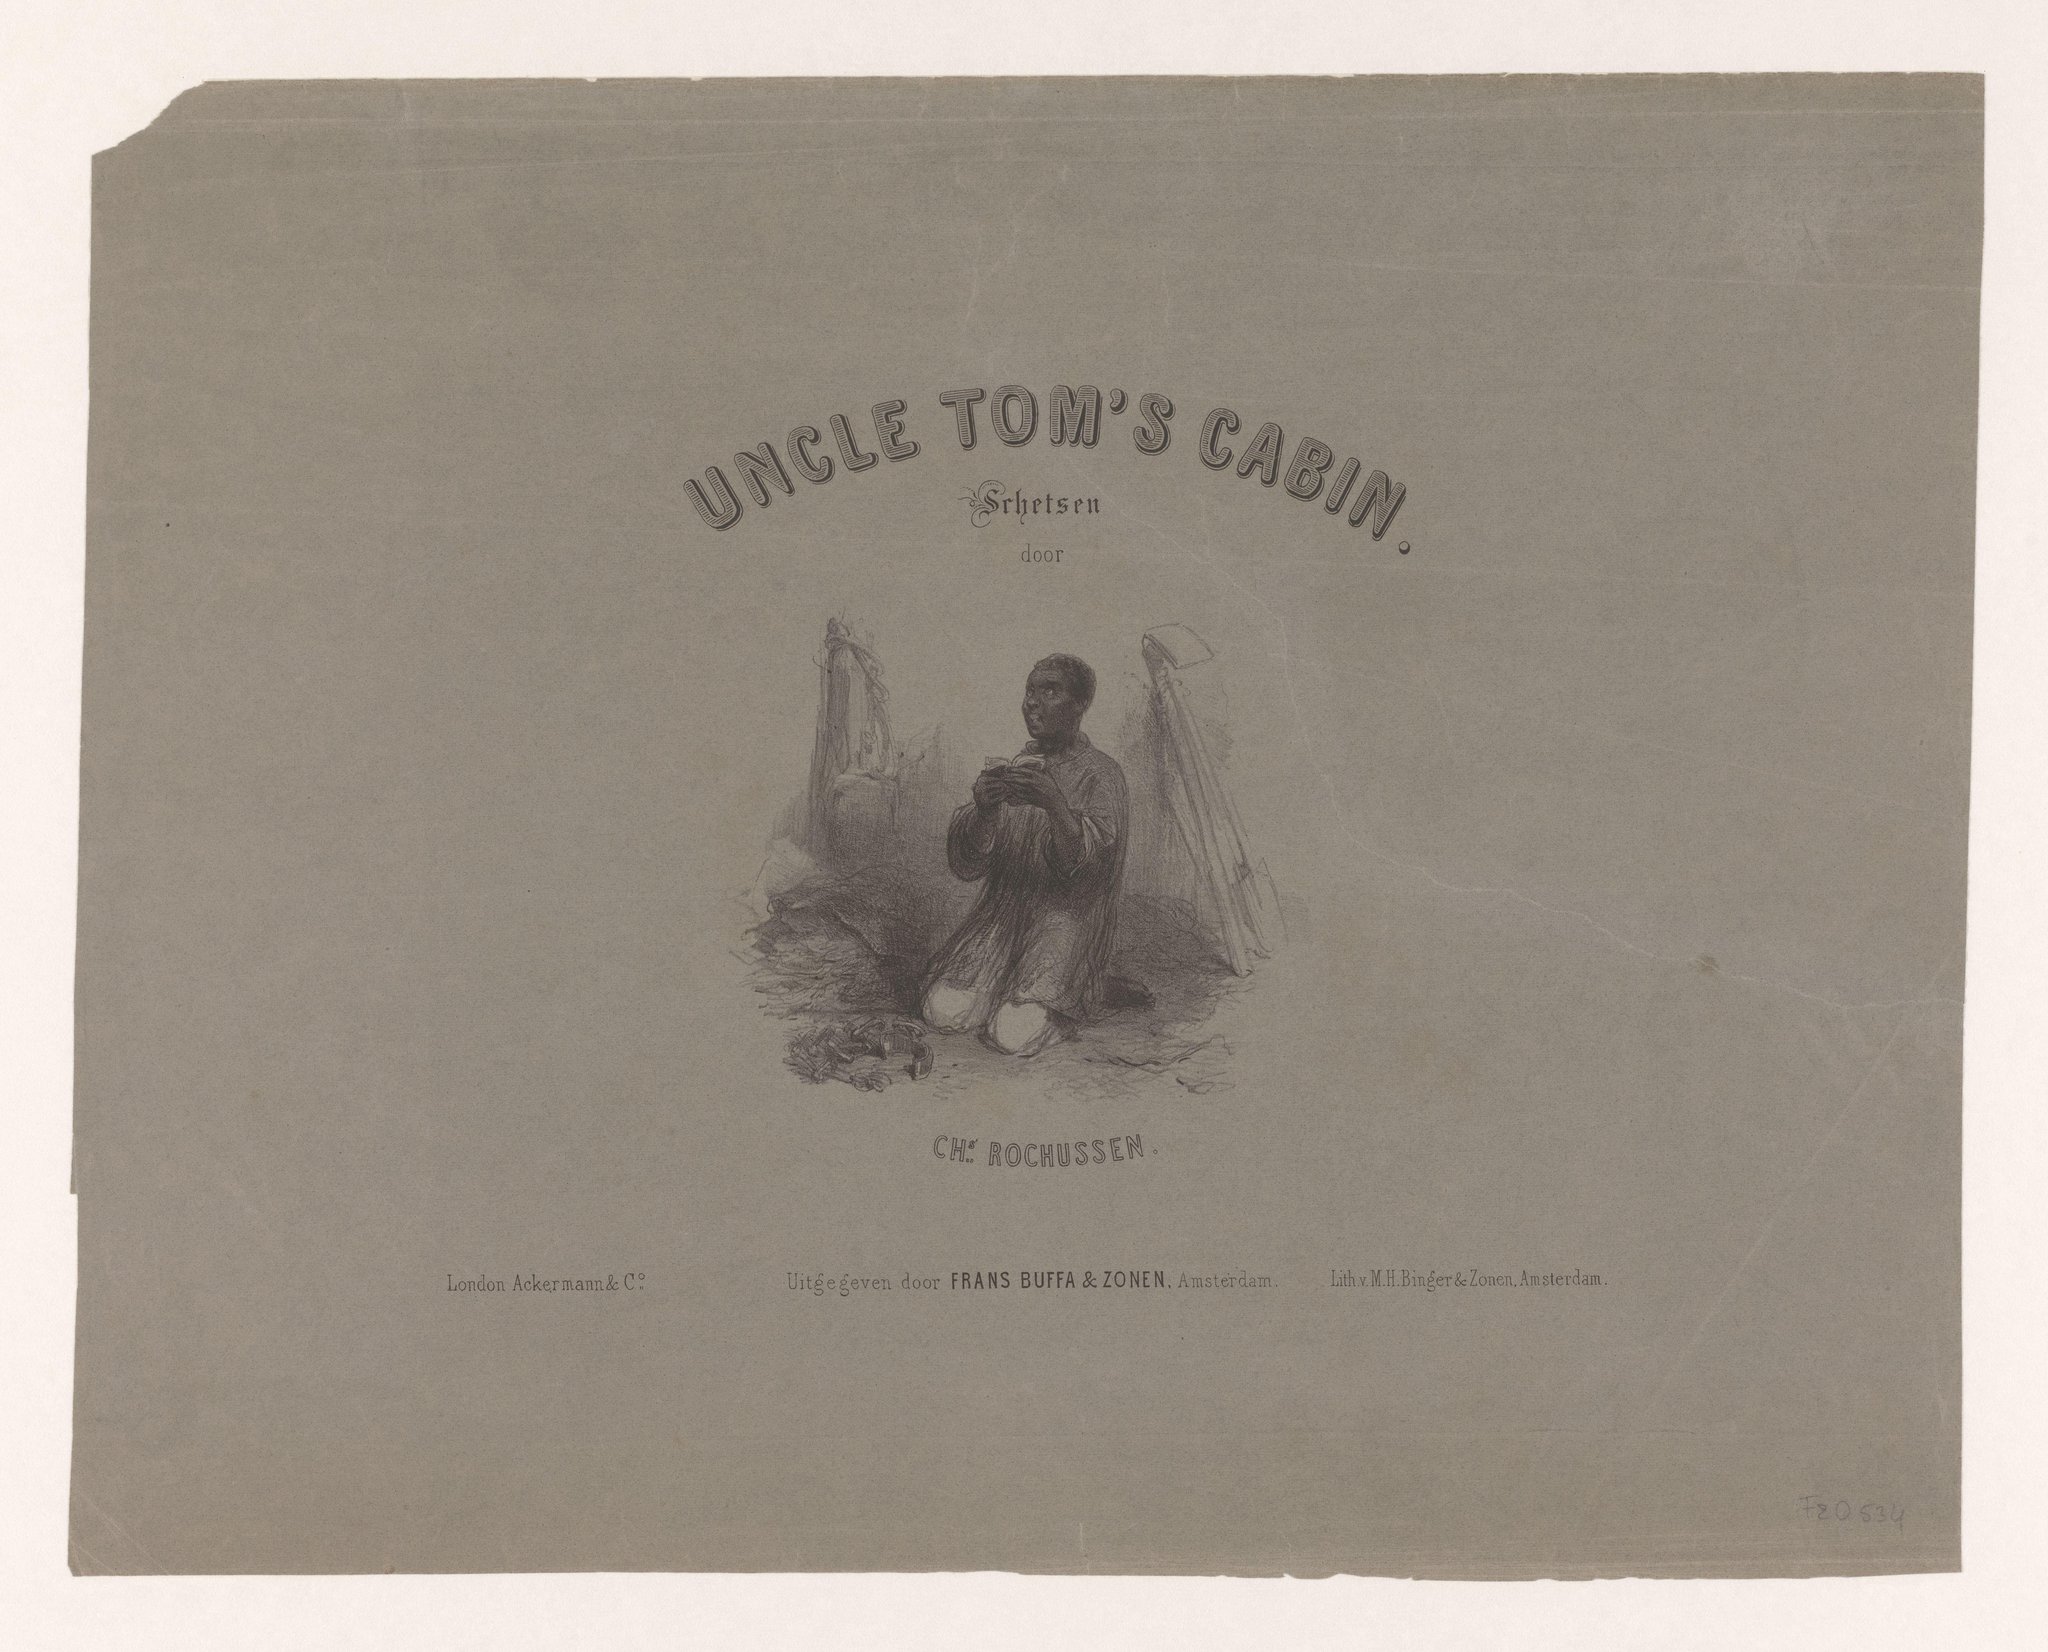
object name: print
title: De hut van oom Tom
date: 1850-1856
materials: paper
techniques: lithograph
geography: london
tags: sitting figure, the bible as a book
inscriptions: collector's mark: Lugt 2228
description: Oom Tom zit op zijn knieën, met een bijbel in zijn handen en zijn ogen richting de hemel kijkend. Voorzijde van een omslag voor een serie van vier lithografieën van scènes uit het verhaal van De hut van oom Tom (Uncle Tom's cabin).